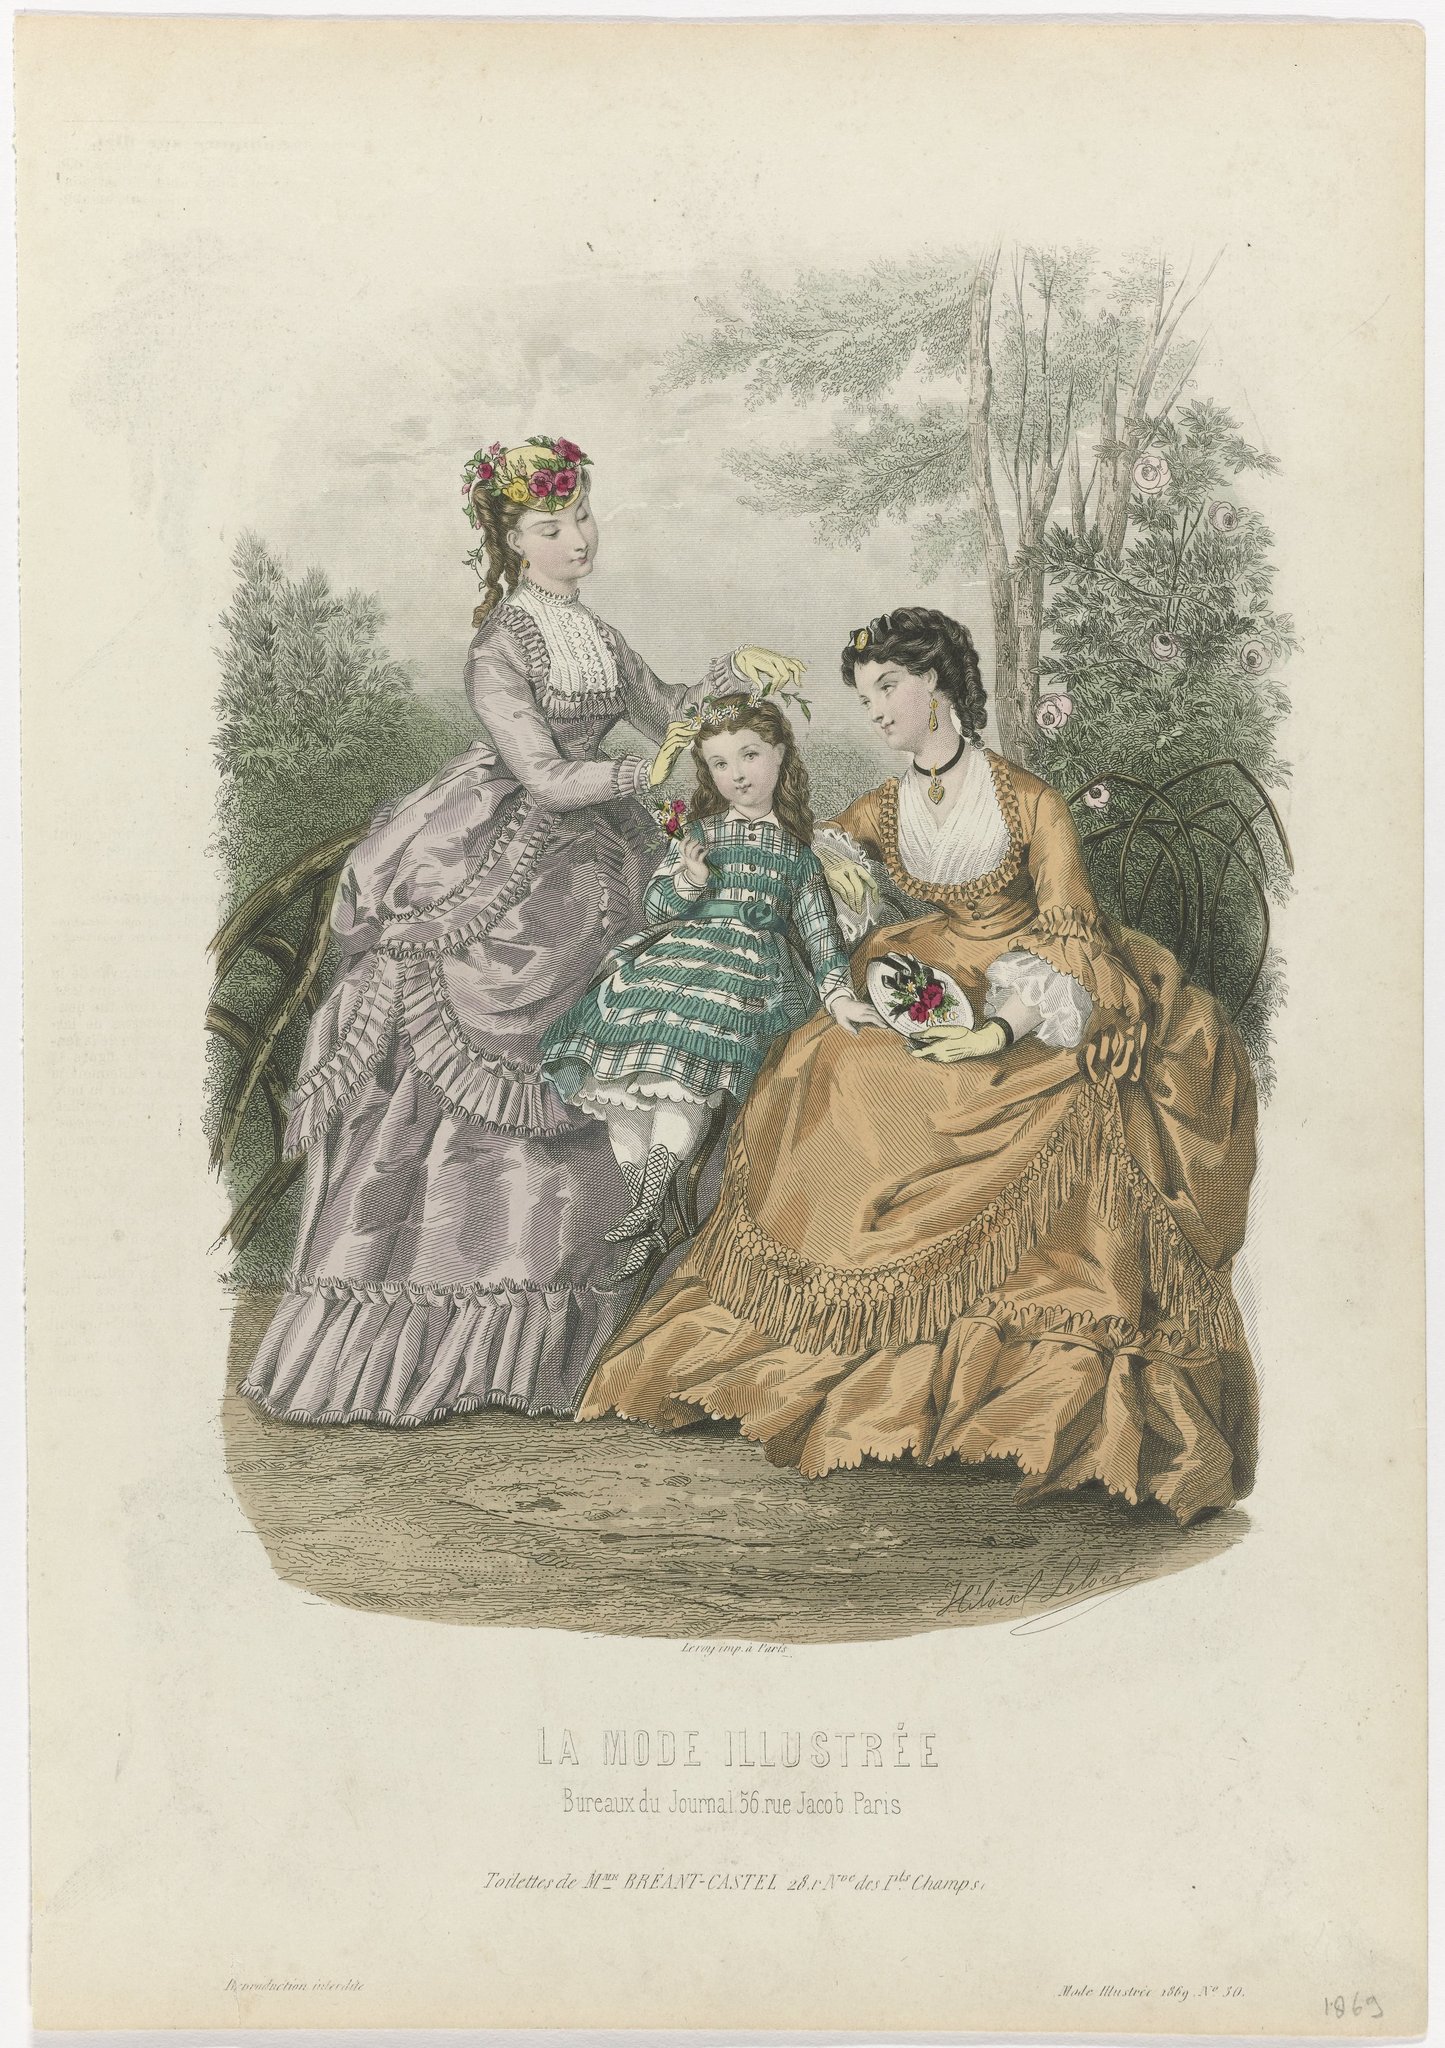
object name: fashion print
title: La Mode Illustrée, 1869, No. 30: Toilettes de Mme Breant-Castel (...)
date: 1869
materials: paper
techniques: hand coloring, engraving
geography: paris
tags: ear-rings (+ women's clothes), pendant, trinket, 'breloque' (+ women's clothes), cut flowers; nosegay, bunch of flowers, head-gear (+ girls' clothes), boots (+ girls' clothes), underclothes for the lower part of the body (+ girls' clothes), head-gear (+ women's clothes), fashion plates, gloves, mittens, etc. (+ women's clothes), dress, gown (+ women's clothes), neck-gear ~ clothing (+ women's clothes), dress, gown (+ girls' clothes)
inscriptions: caption: ‘Toilettes de M.me Breant-Castel 28.r Nve des P.ts Champs.’, title: ‘La Mode Illustrée’, address: ‘Bureaux du Journal, 56, Rue Jacob. Paris’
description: Twee vrouwen en een meisje zitten buiten. Een vrouw doet een bloemenkrans in het haar van het meisje. Volgens het onderschrift: ensembles van Bréant-Castel. Prent uit het modetijdschrift La Mode Illustrée (1860-1937).